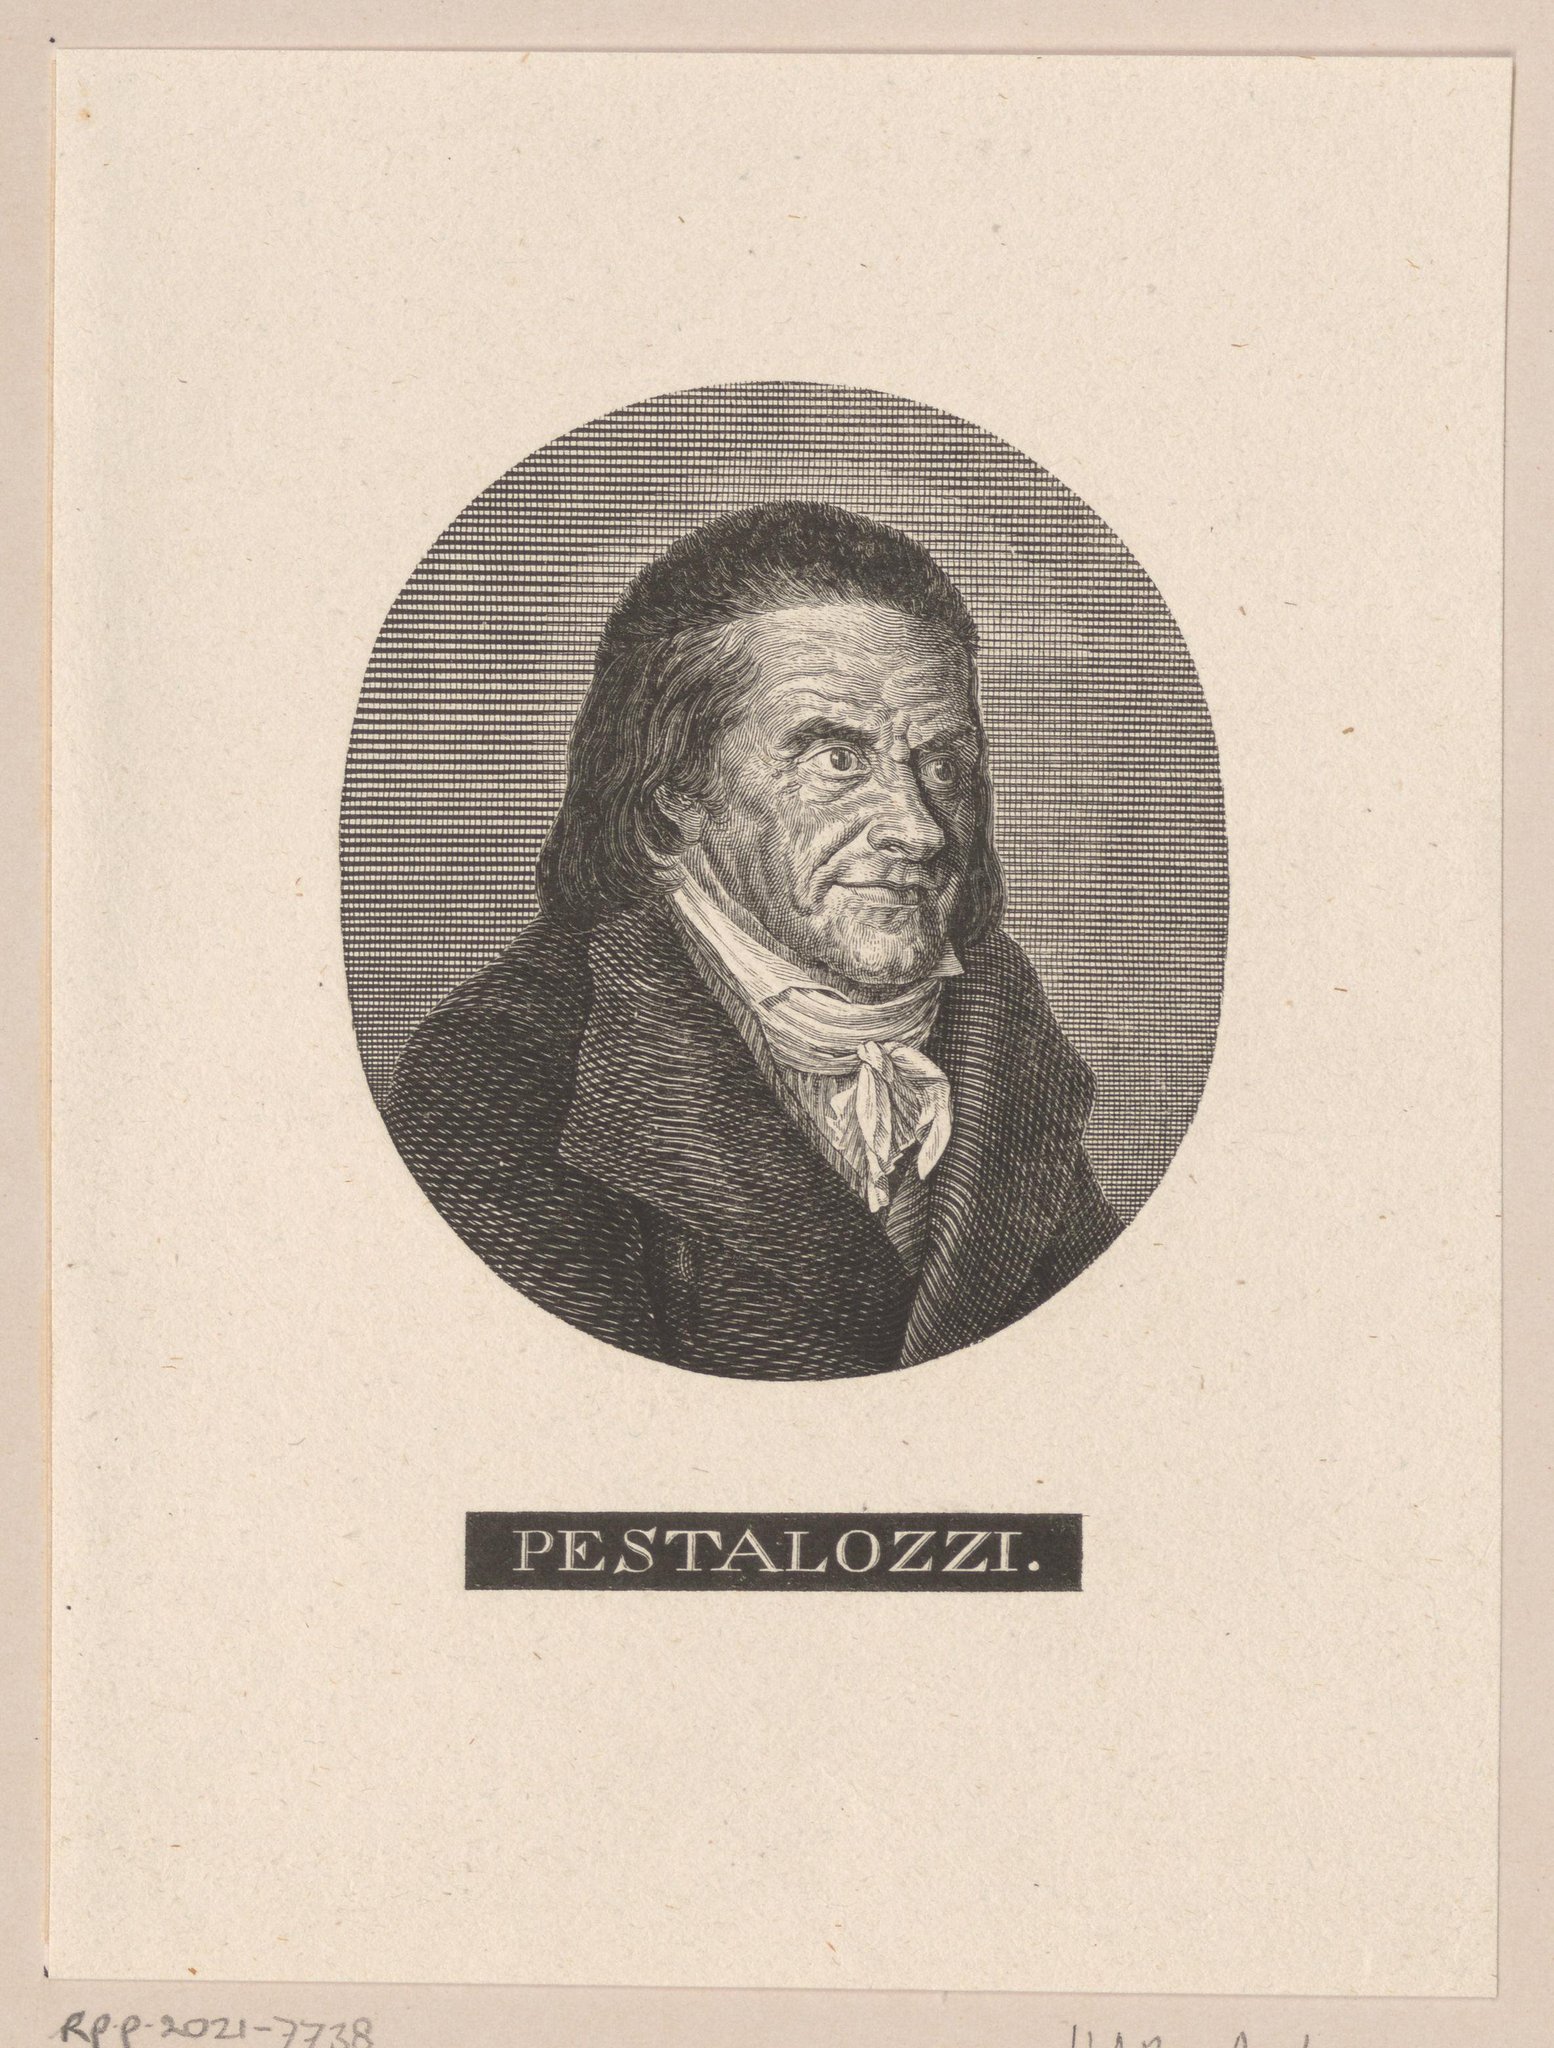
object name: print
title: Portret van Johann Heinrich Pestalozzi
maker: Anonymous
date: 1800-1849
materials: paper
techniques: engraving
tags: politician, adult man, historical persons